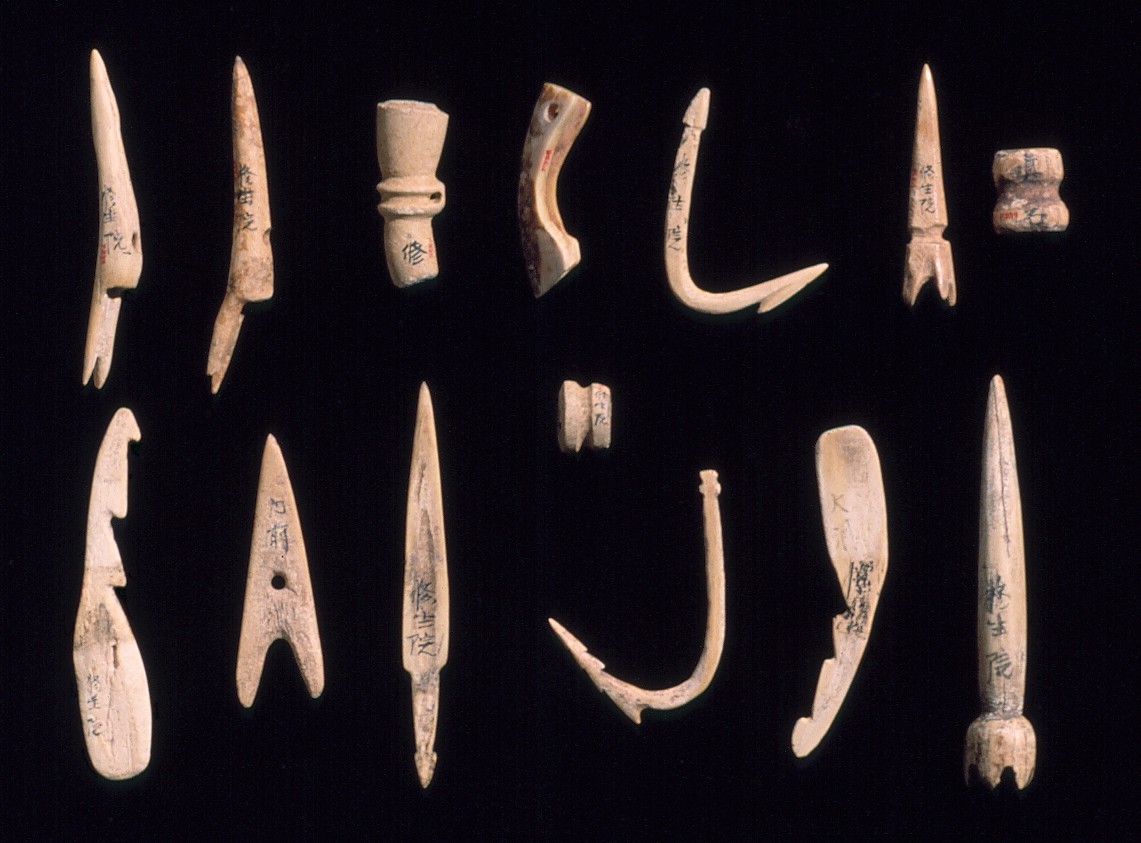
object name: needle, hook, and harpoon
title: Needles, hooks, and harpoon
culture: japanese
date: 1000-300 BCE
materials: bone